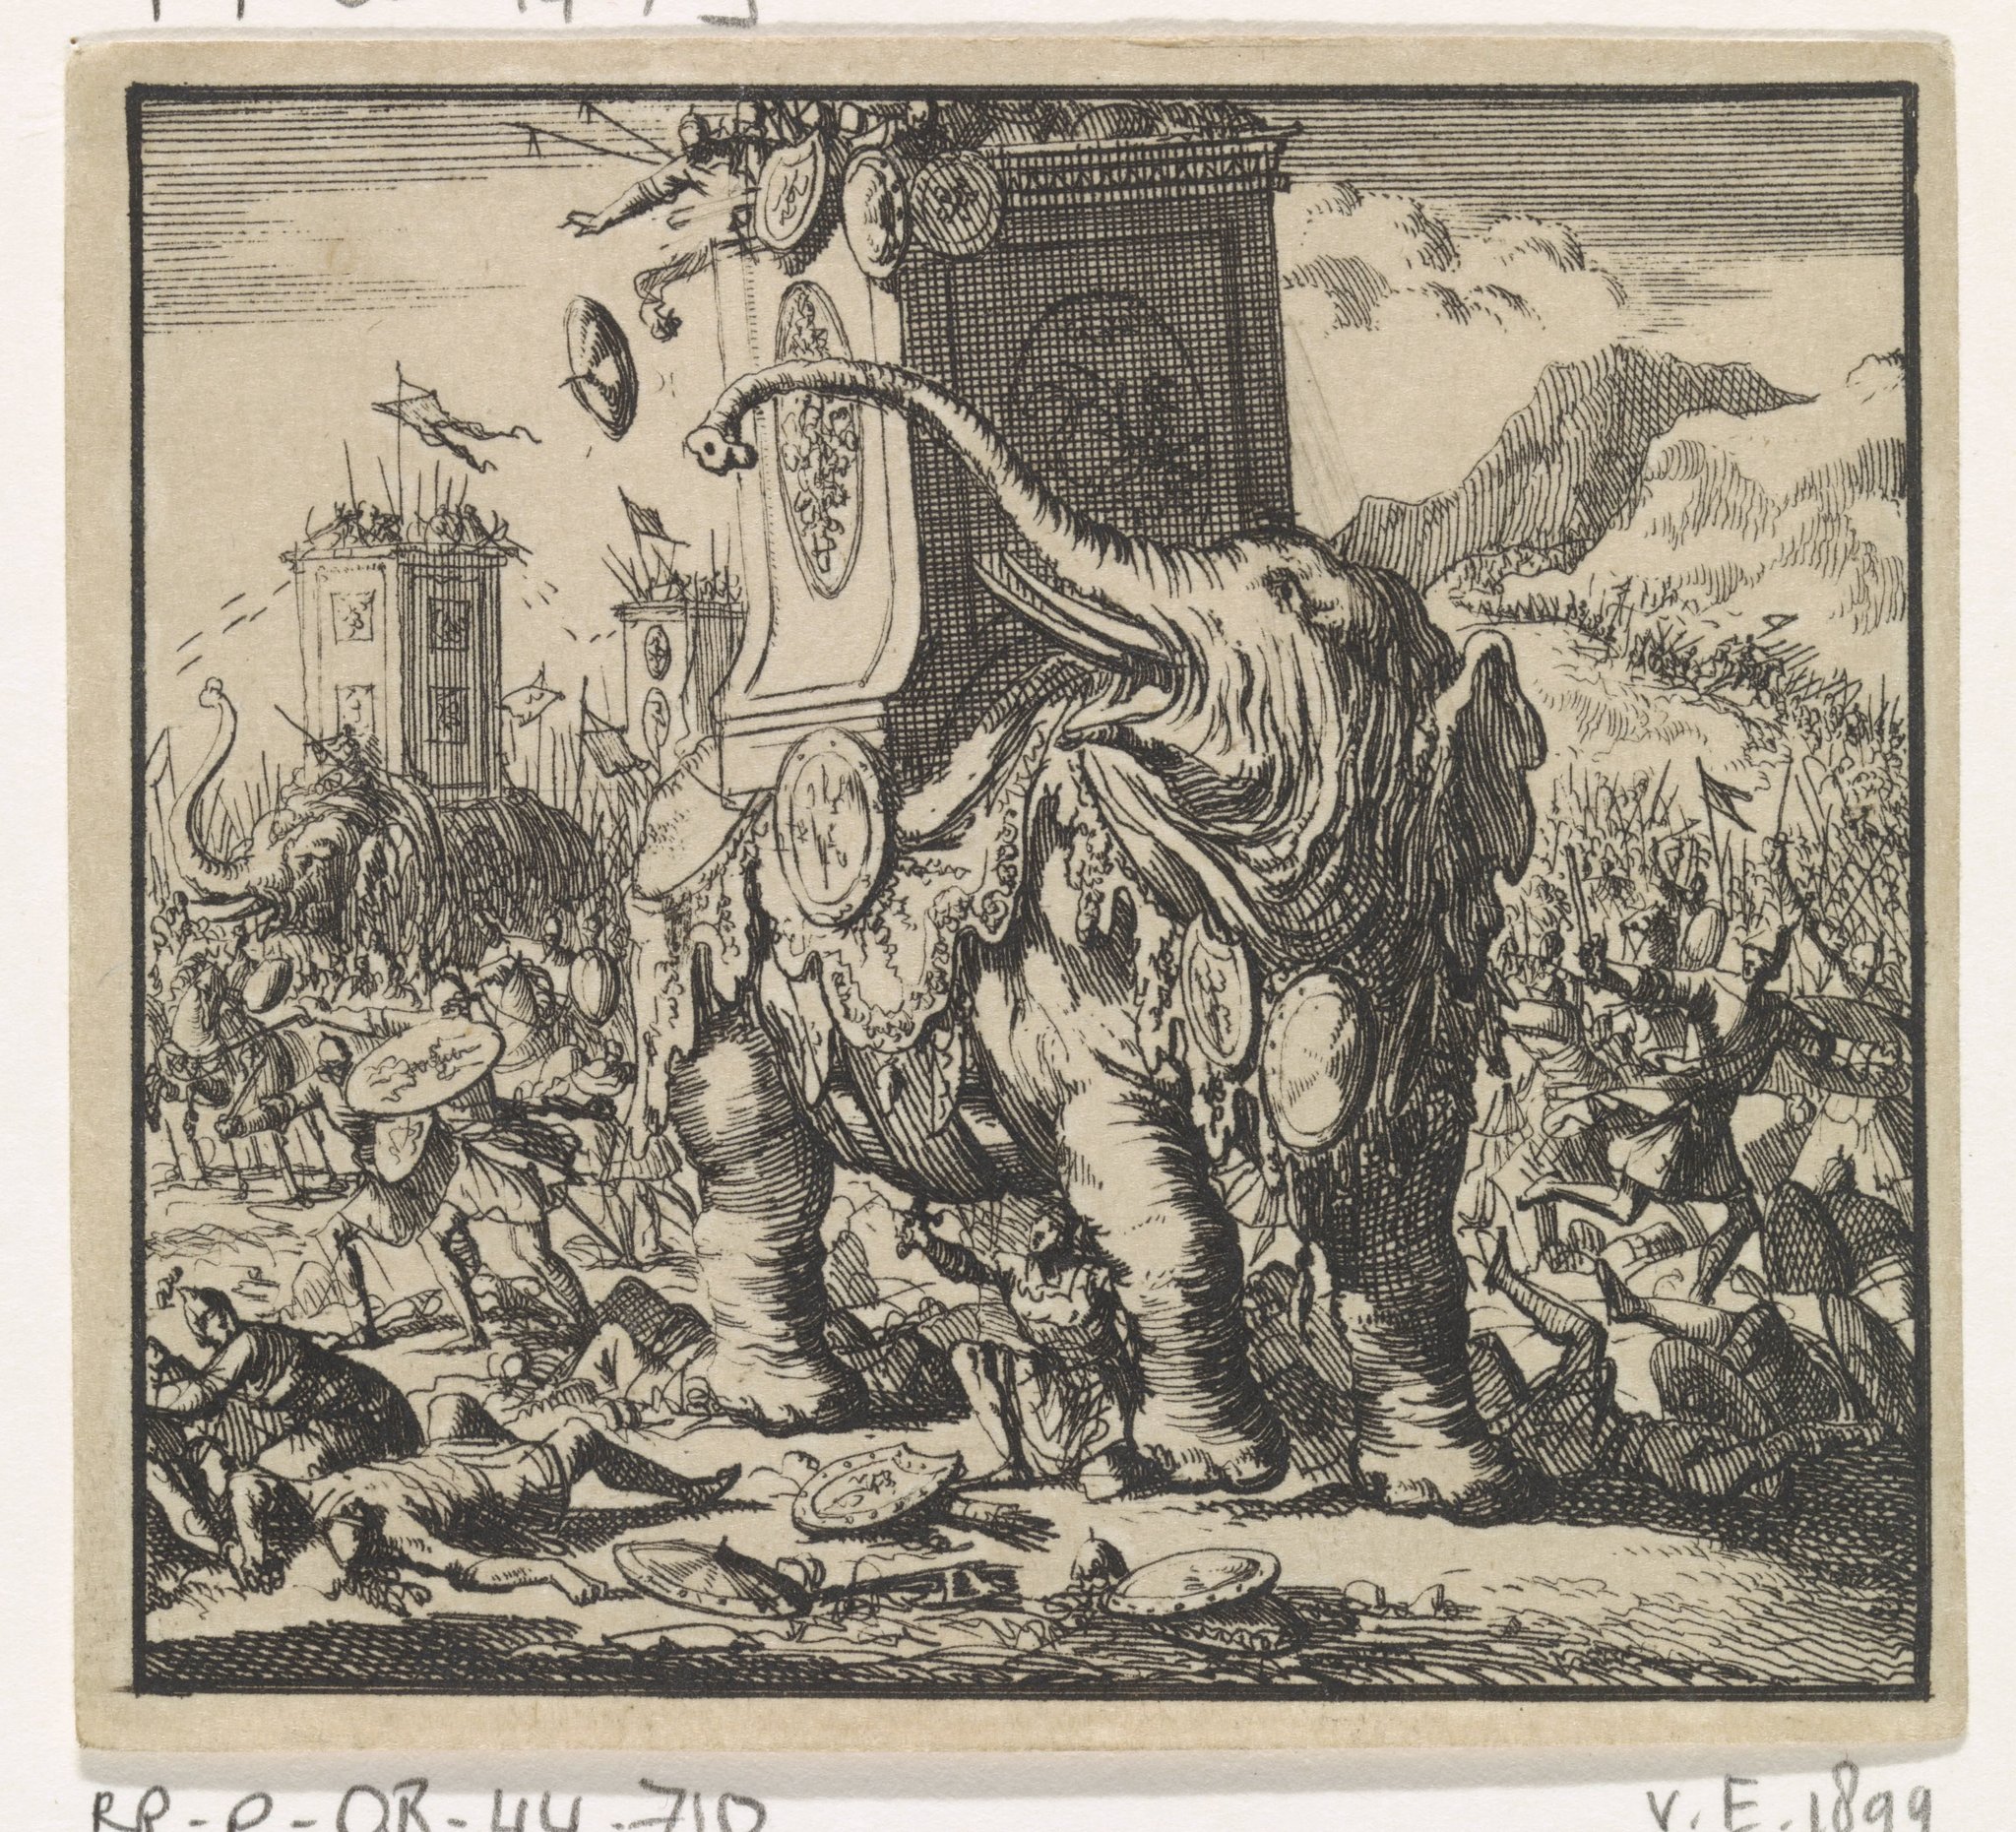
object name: print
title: Eleazar doodt de gewapende olifant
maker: jan luyken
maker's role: draughtsman, print maker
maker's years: 1649-1712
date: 1698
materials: paper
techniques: etching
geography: amsterdam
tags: eleazar, brother of judas maccabeus, kills an elephant of war and is killed himself when the elephant falls on him, trunked animals: elephant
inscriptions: collector's mark: Lugt 2228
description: Proefdruk van illustratie uit: Josephus, Flavius. XX. boeken van de oude geschiedenissen der joden, 4 delen. Amsterdam: Barent Visscher, Willem de Coup, Willem van Lamsveld, Andries van Damme, 1698, dl. II.